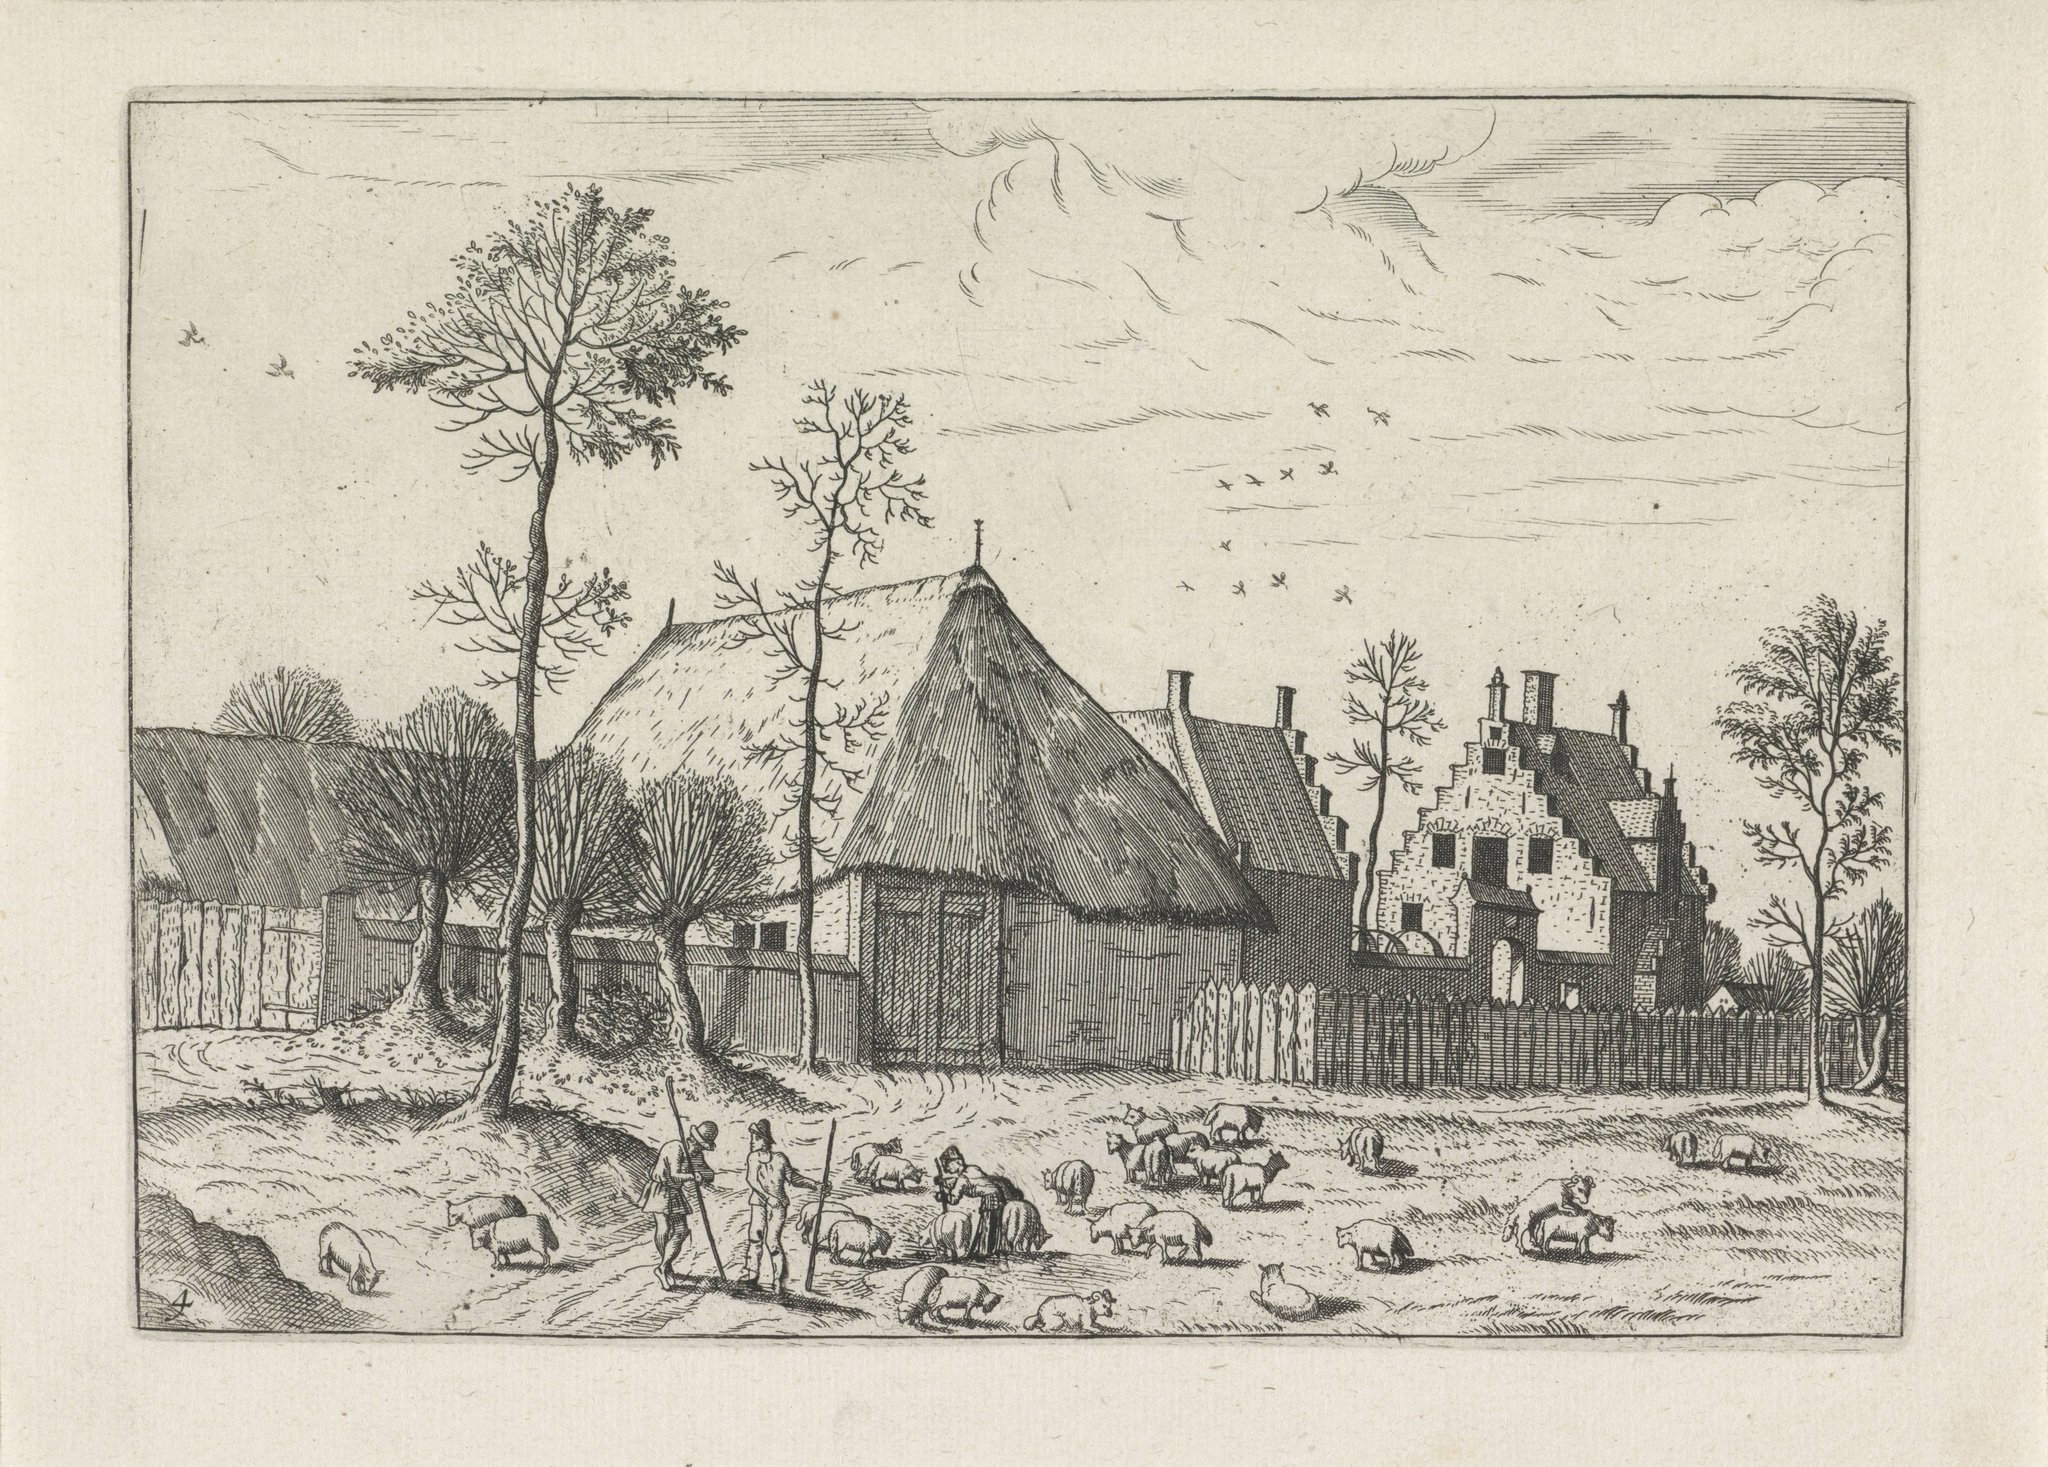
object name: print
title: Kleine landschappen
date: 1559-1561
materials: paper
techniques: etching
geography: antwerp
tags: herding, herdsman, herdswoman, shepherd, shepherdess, cowherd, etc., shed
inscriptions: collector's mark: Lugt 2228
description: Een boerenschuur en huis met trapgevel. Op de voorgrond twee herders met een kudde schapen.